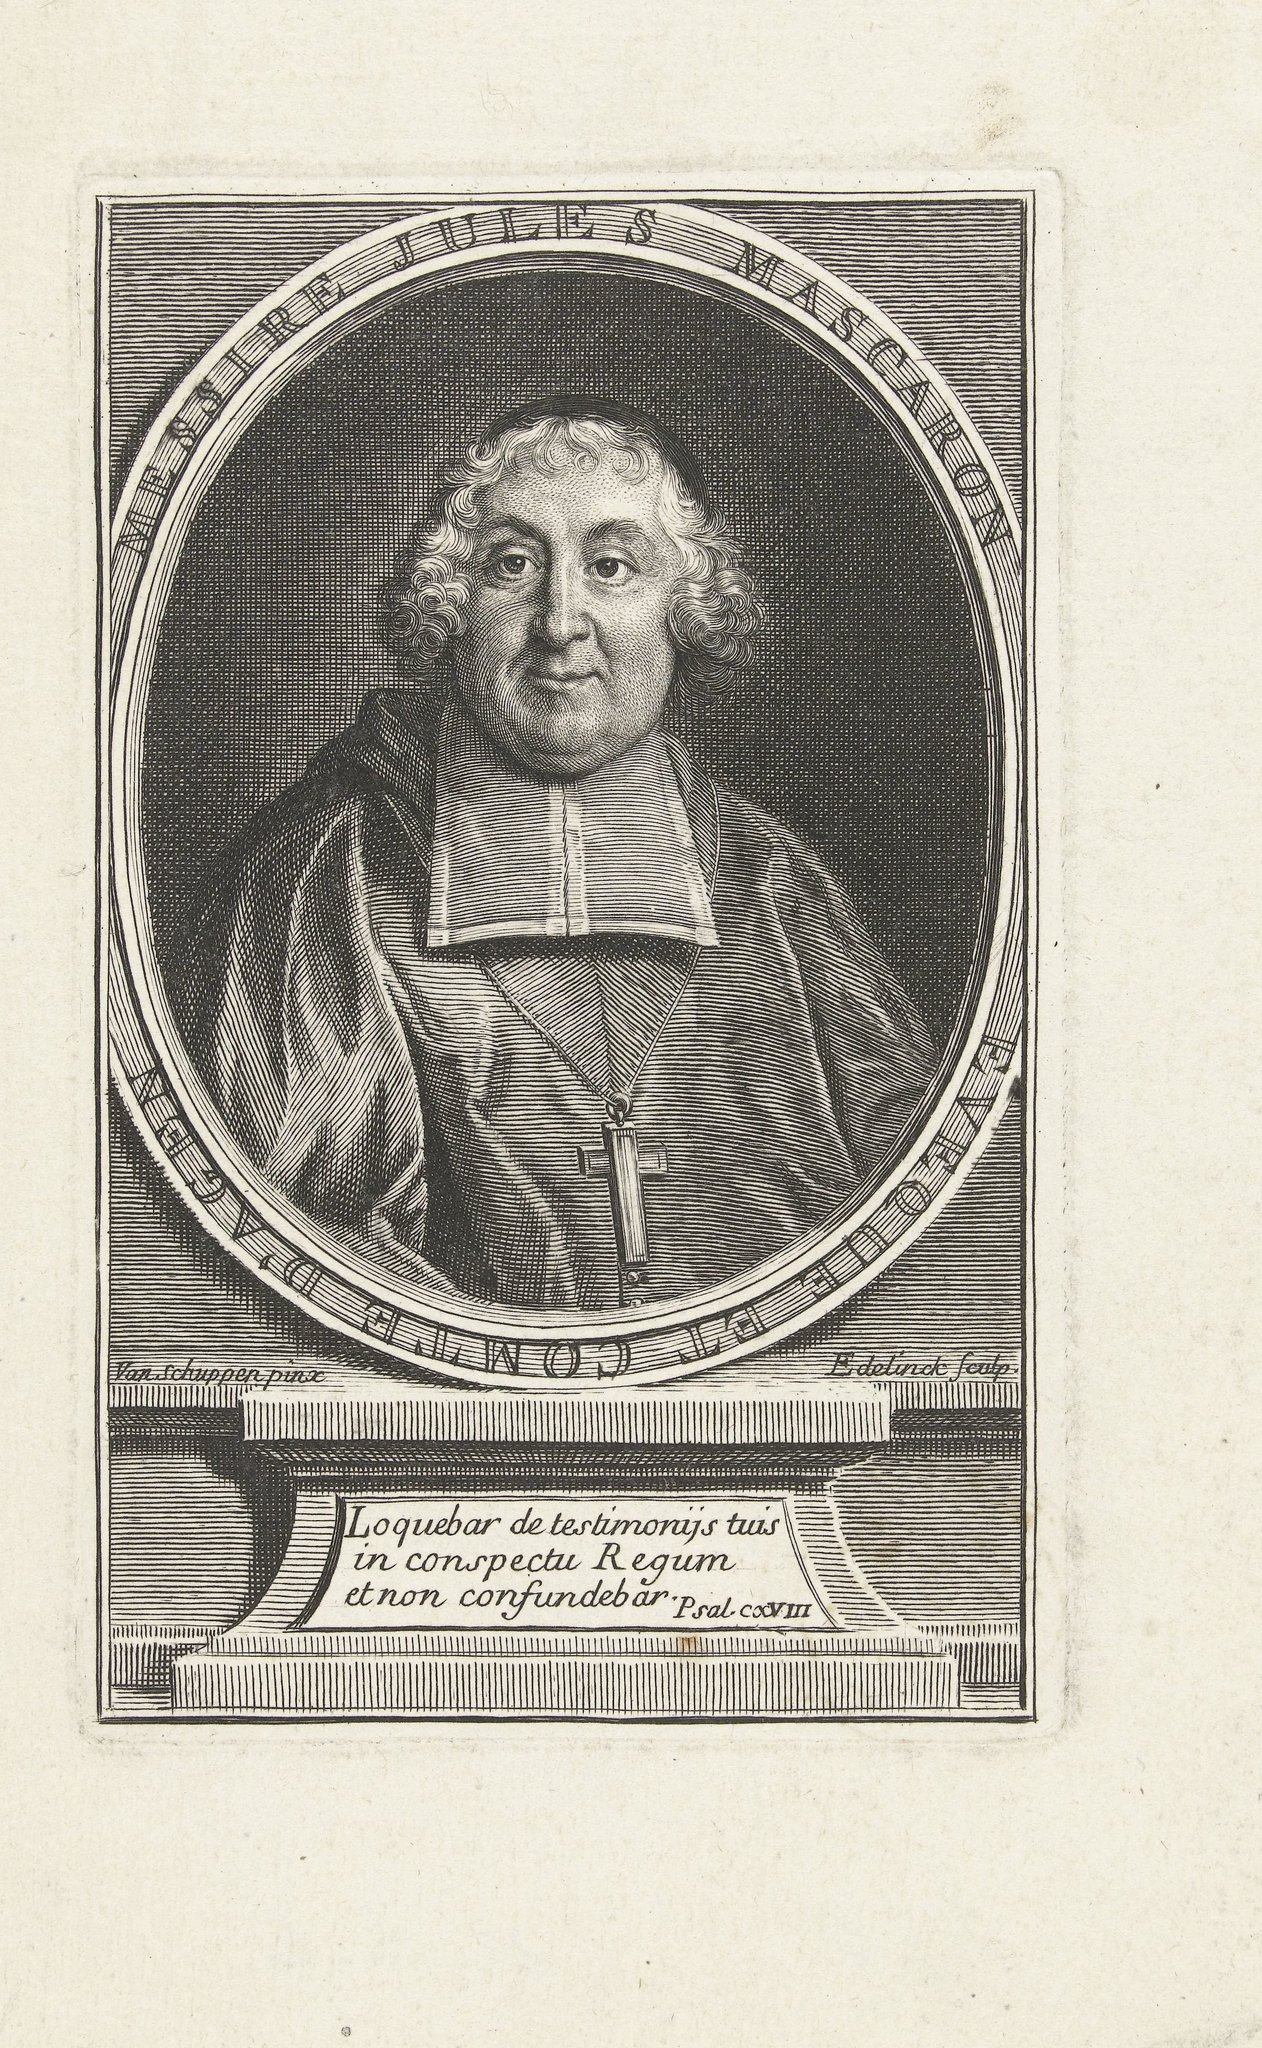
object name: print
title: Portret van Jules Mascaron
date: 1666-1707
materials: paper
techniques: engraving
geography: france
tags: bisschop, jules mascaron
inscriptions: collector's mark: Lugt 240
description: Portret van de Franse predikant en bisschop Jules Mascaron (1634-1703), afgebeeld in ovale omlijsting met tekst. Onder de lijst een console met drie regels tekst in Latijn.